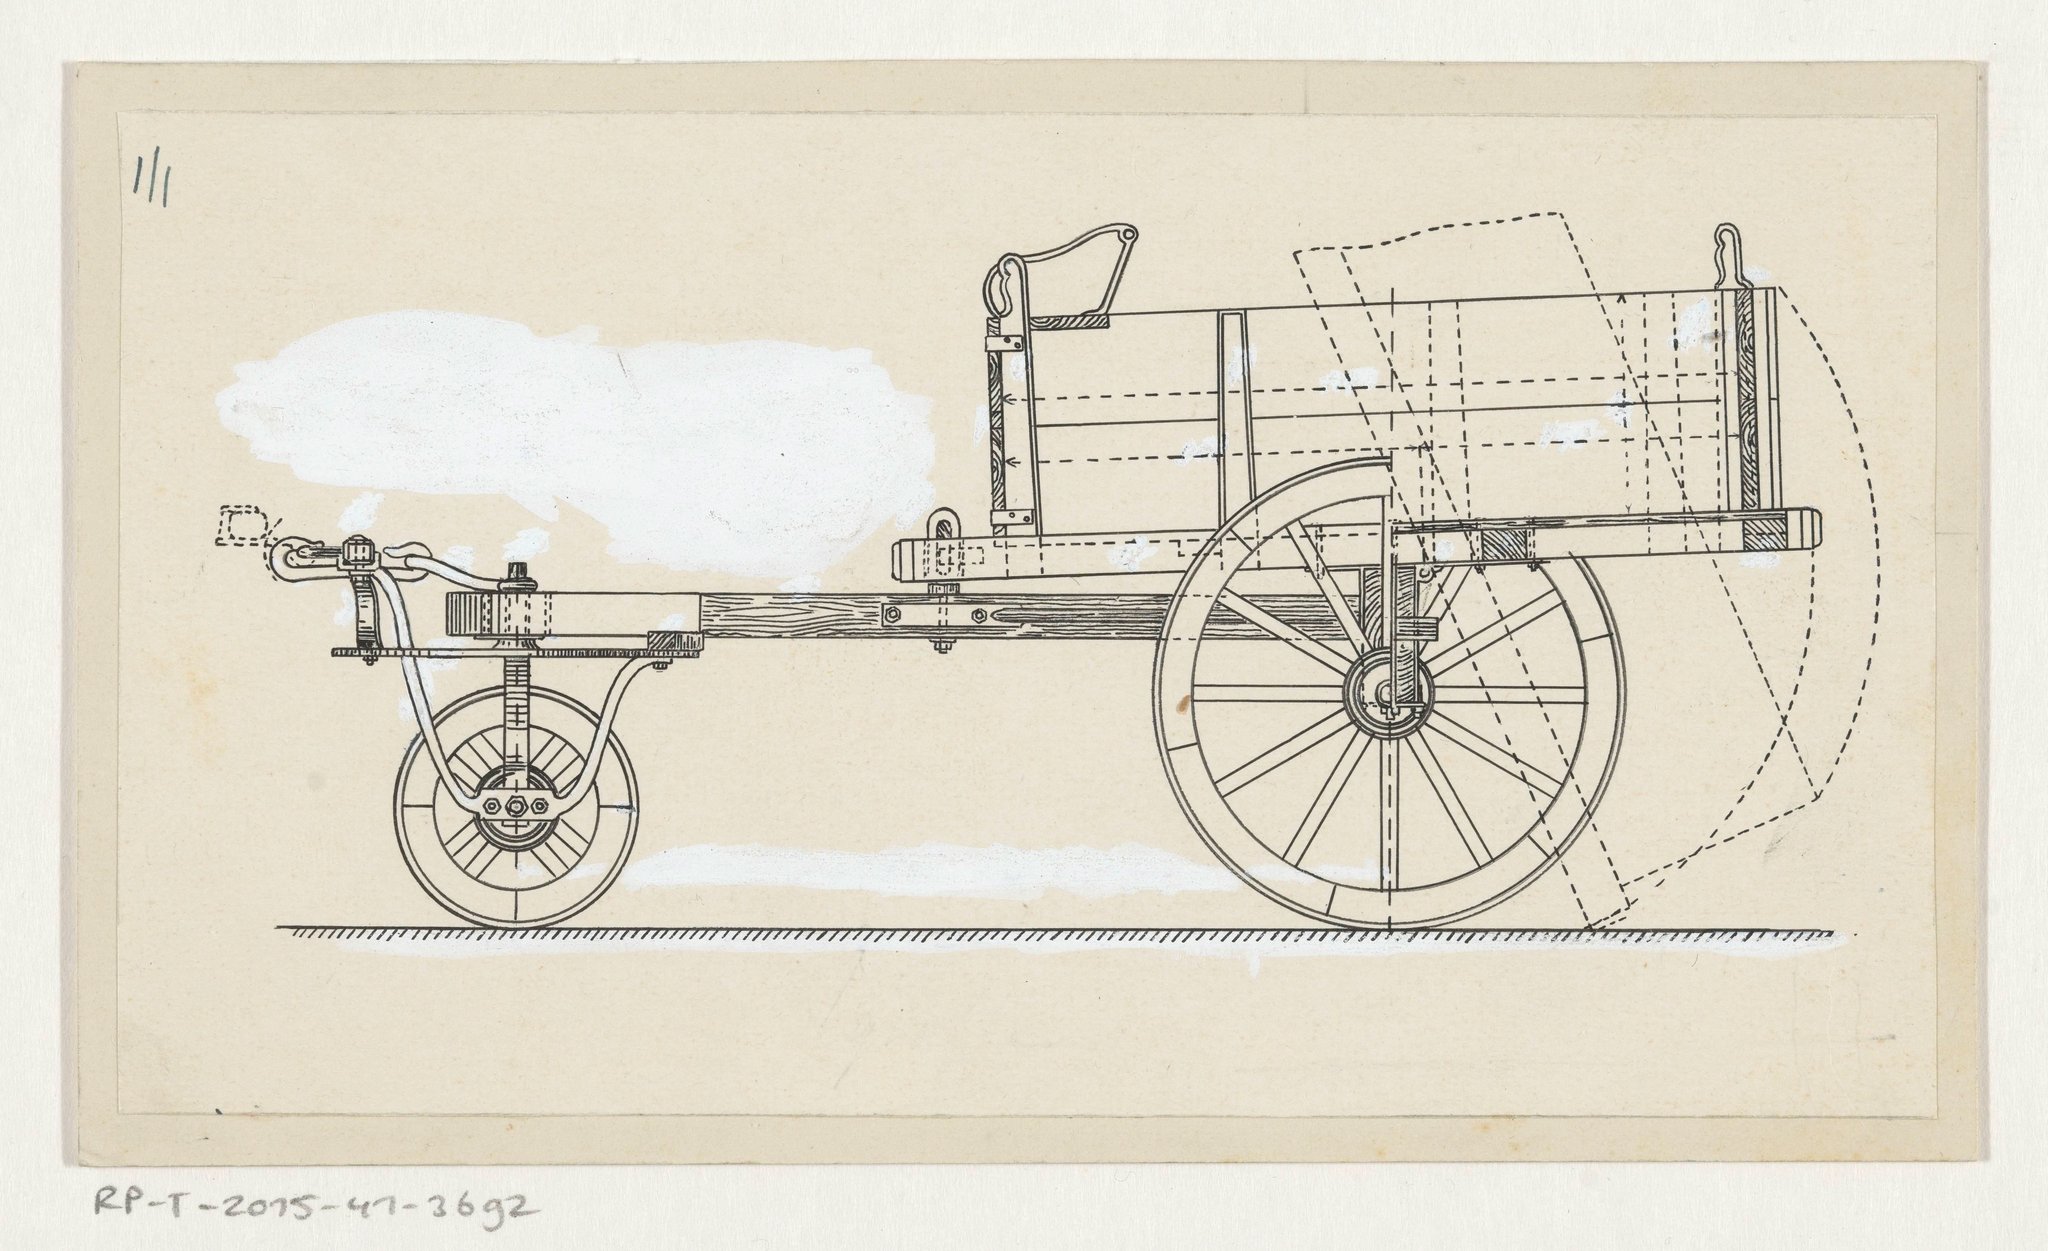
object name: drawing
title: Aanhangwagen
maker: Anonymous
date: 1910-1940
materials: cardboard, paint, ink, paper, pencil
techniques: brush, pen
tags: traffic on land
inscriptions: collector's mark: Lugt 2228a, number: ‘III’, :